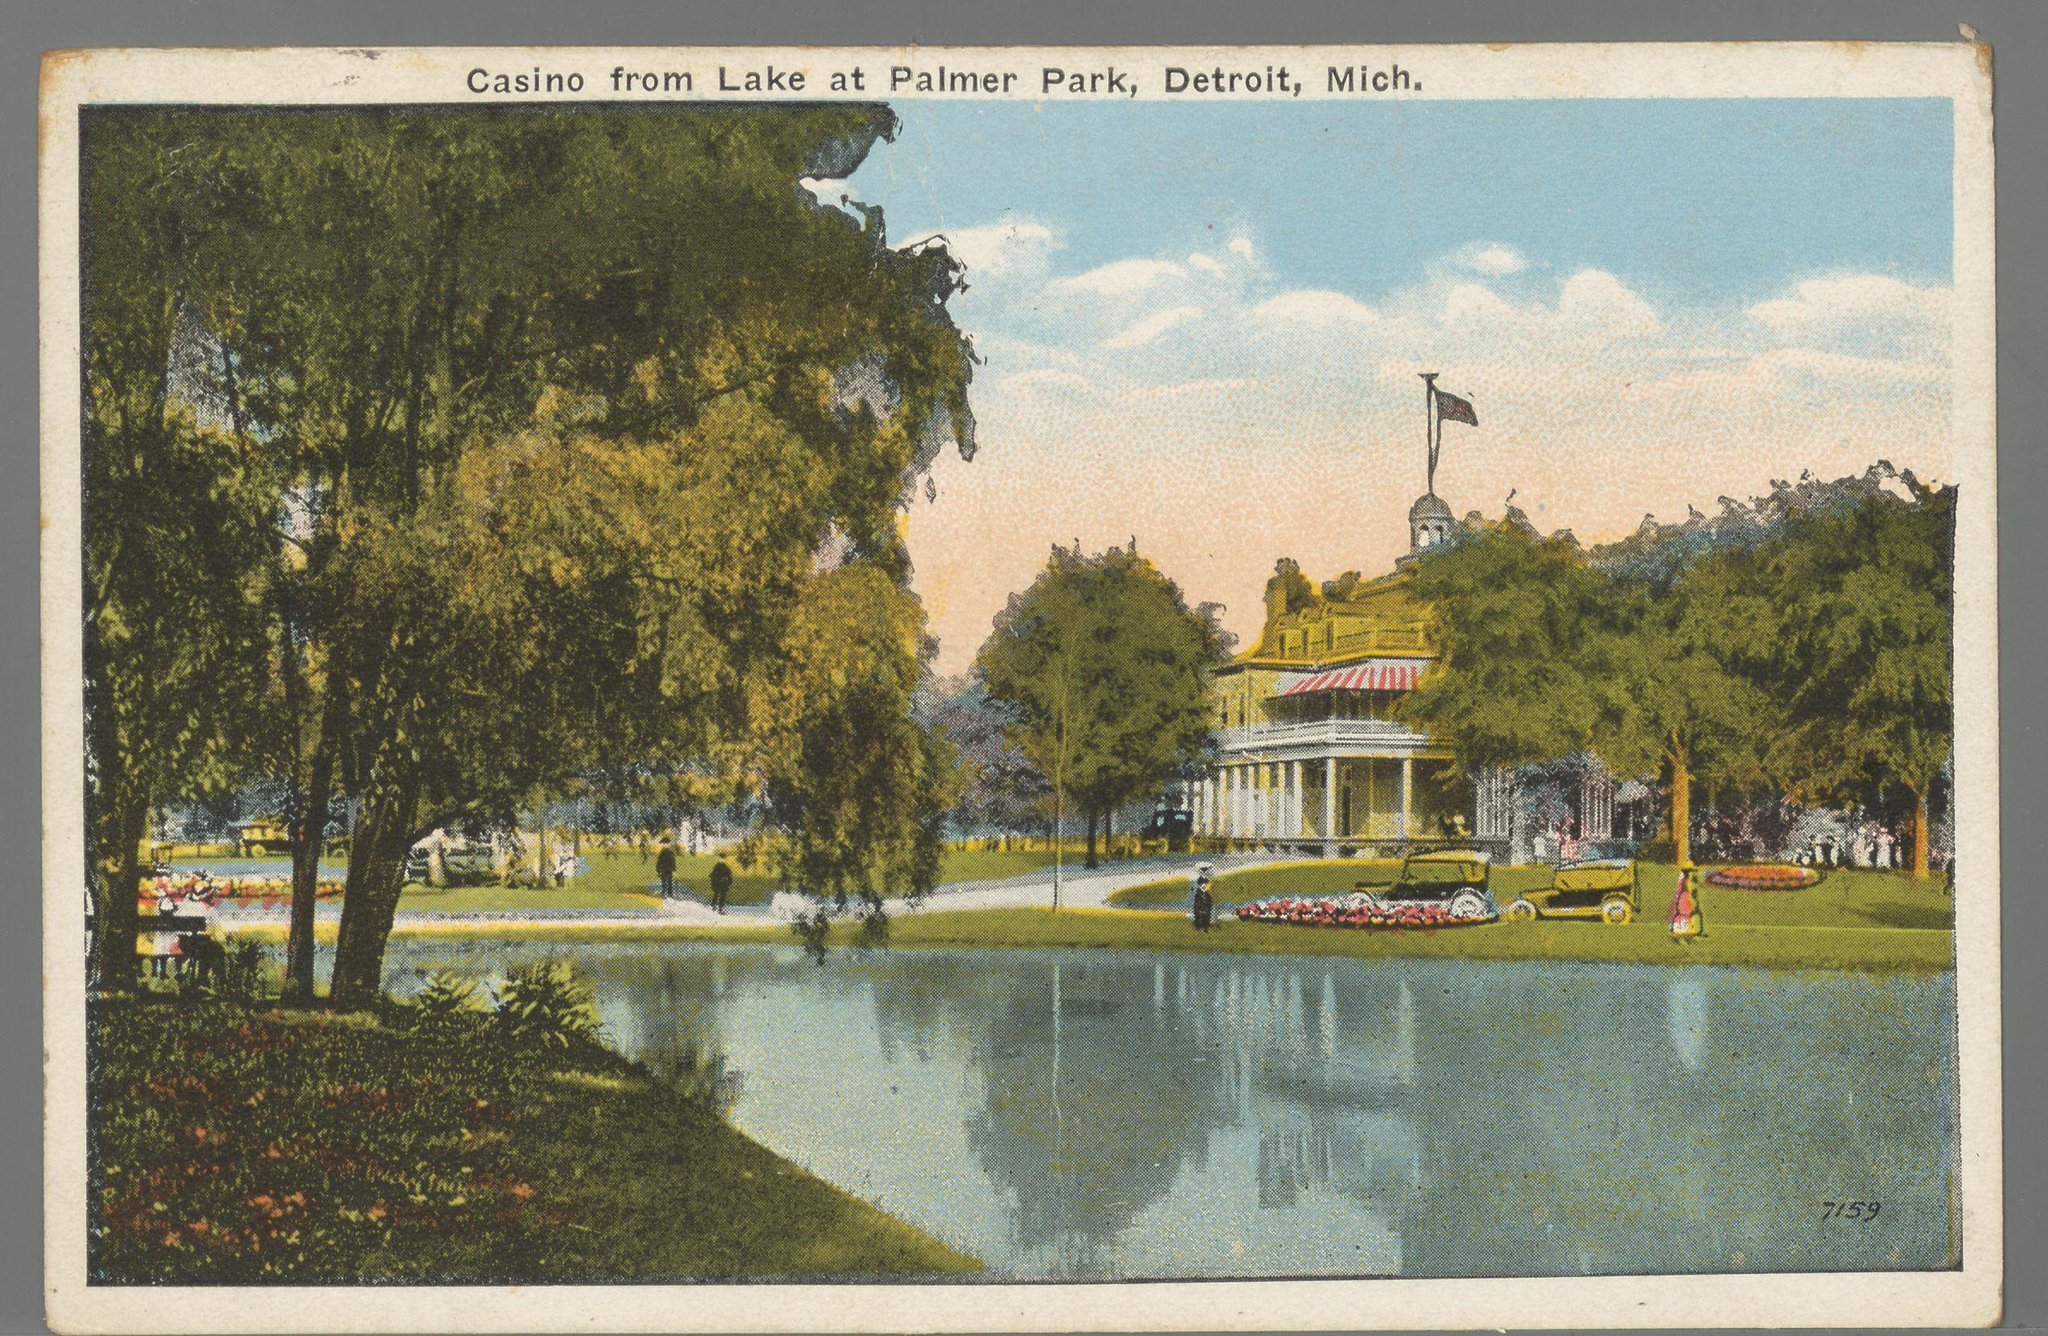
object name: photomechanical print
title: Casino from Lake at Palmer Park, Detroit, Mich.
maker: Anonymous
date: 1895-1924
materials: cardboard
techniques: lithograph, writing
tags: casino, public gardens, park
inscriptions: poststempel, verso, gestempeld